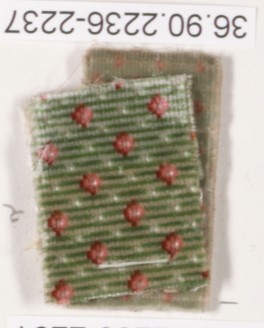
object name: piece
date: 1801-1900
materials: silk